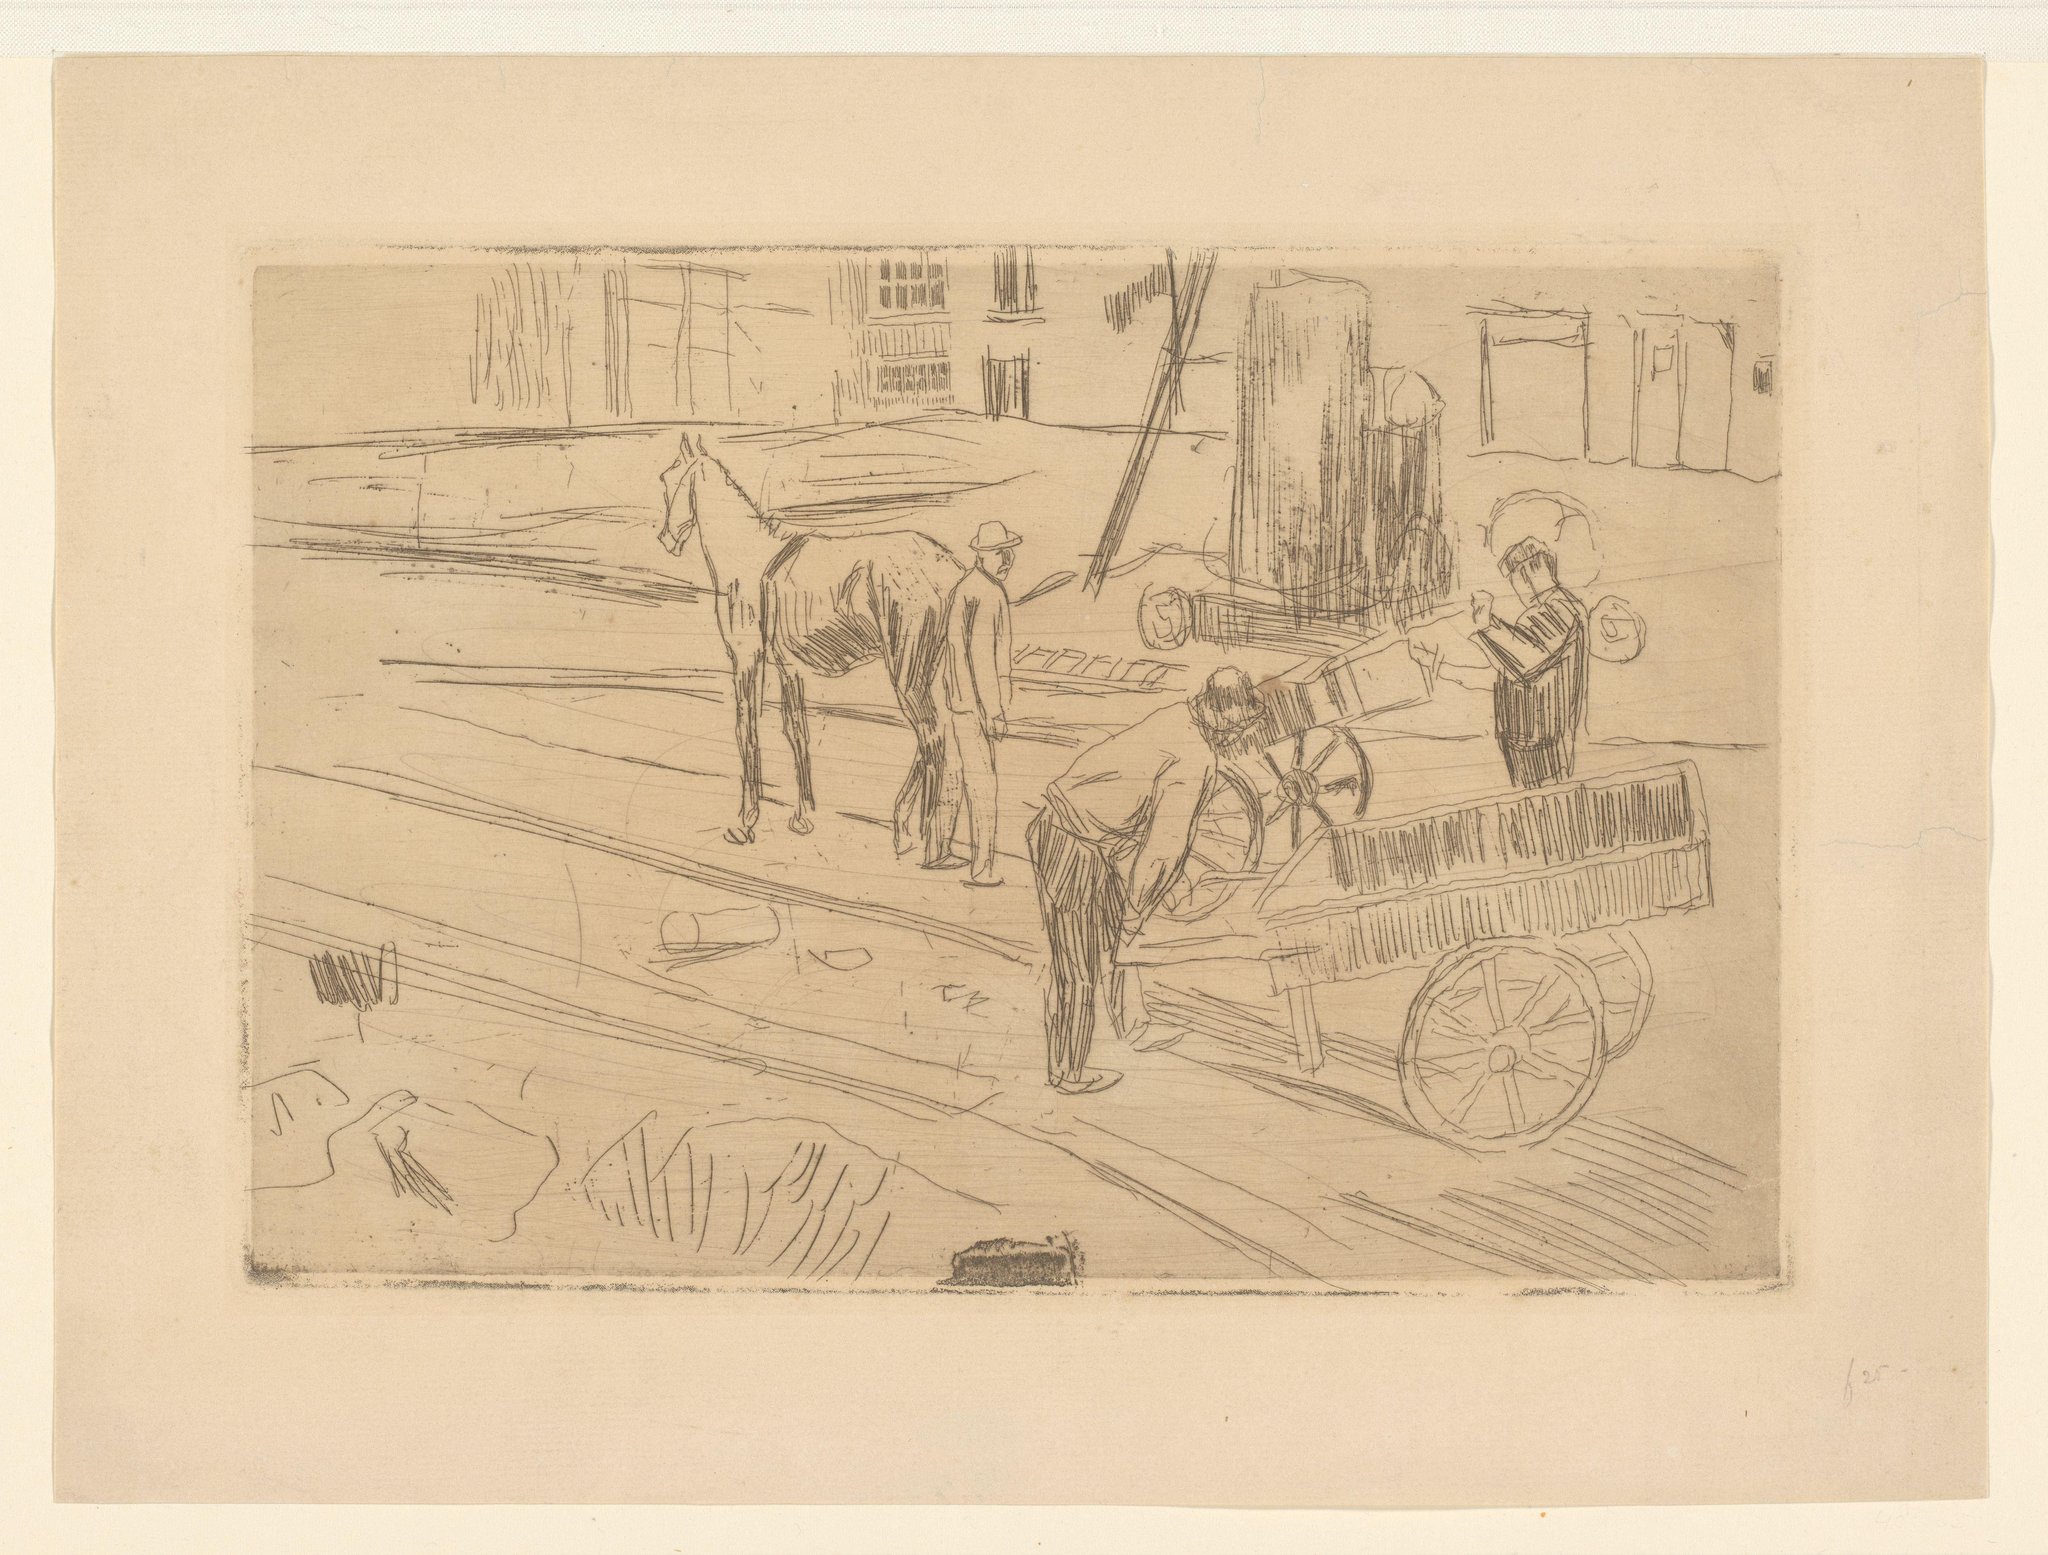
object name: print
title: Heiwerk met karren en paard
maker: george hendrik breitner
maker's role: draughtsman, painter, print maker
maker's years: 1857-1923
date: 1903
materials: paper, ink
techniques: drypoint, etching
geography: amsterdam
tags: horse, (farm) wagon, freight wagon, cart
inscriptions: inscription: ‘f 25’, collector's mark: Lugt 2228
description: Gezicht op een straat met drie mannen, twee karren en een paard; schetsmatig weergegeven.